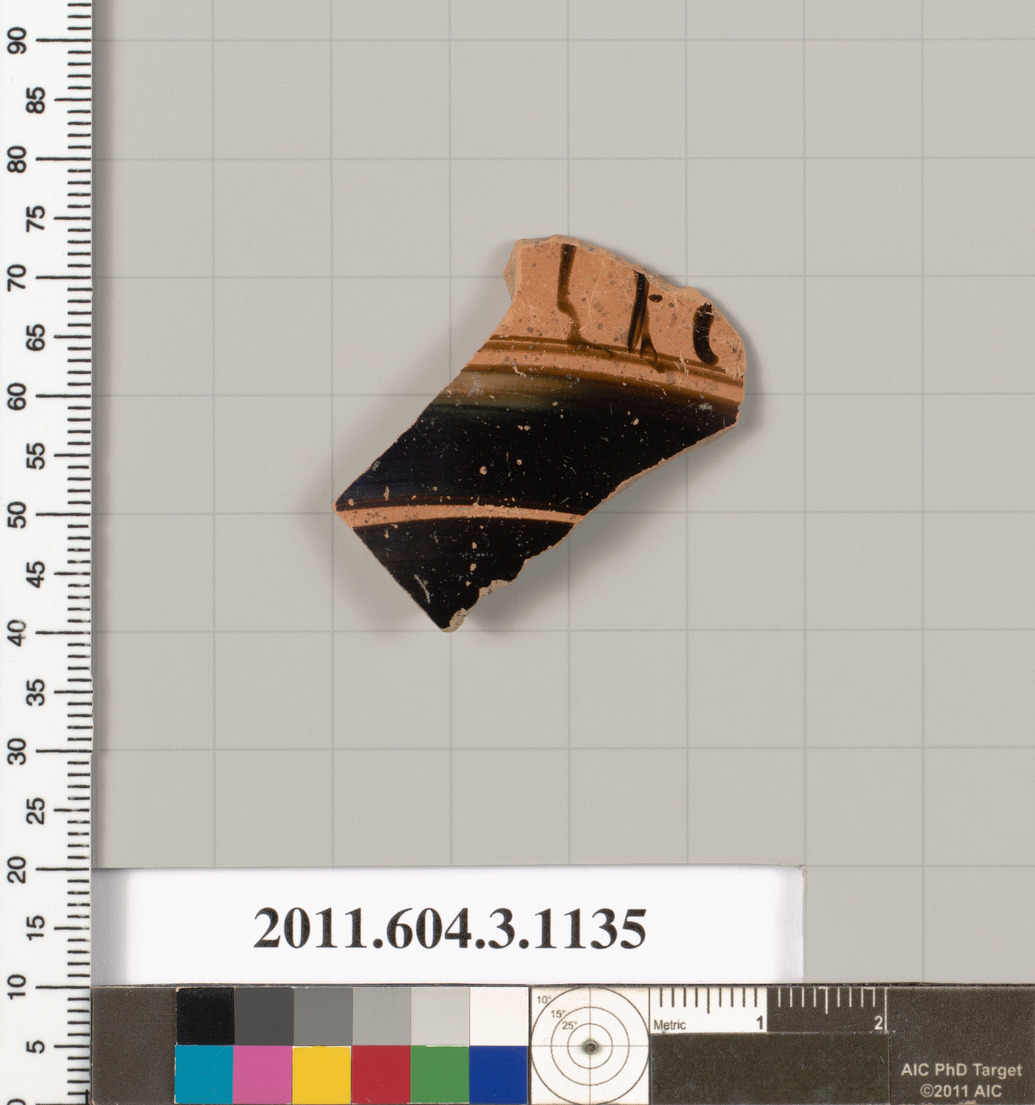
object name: mastoid or kyathos fragment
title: Terracotta fragment of a mastoid (drinking cup with narrow base) or a kyathos (cup-shaped ladle)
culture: greek, attic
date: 534-468 BCE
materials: terracotta